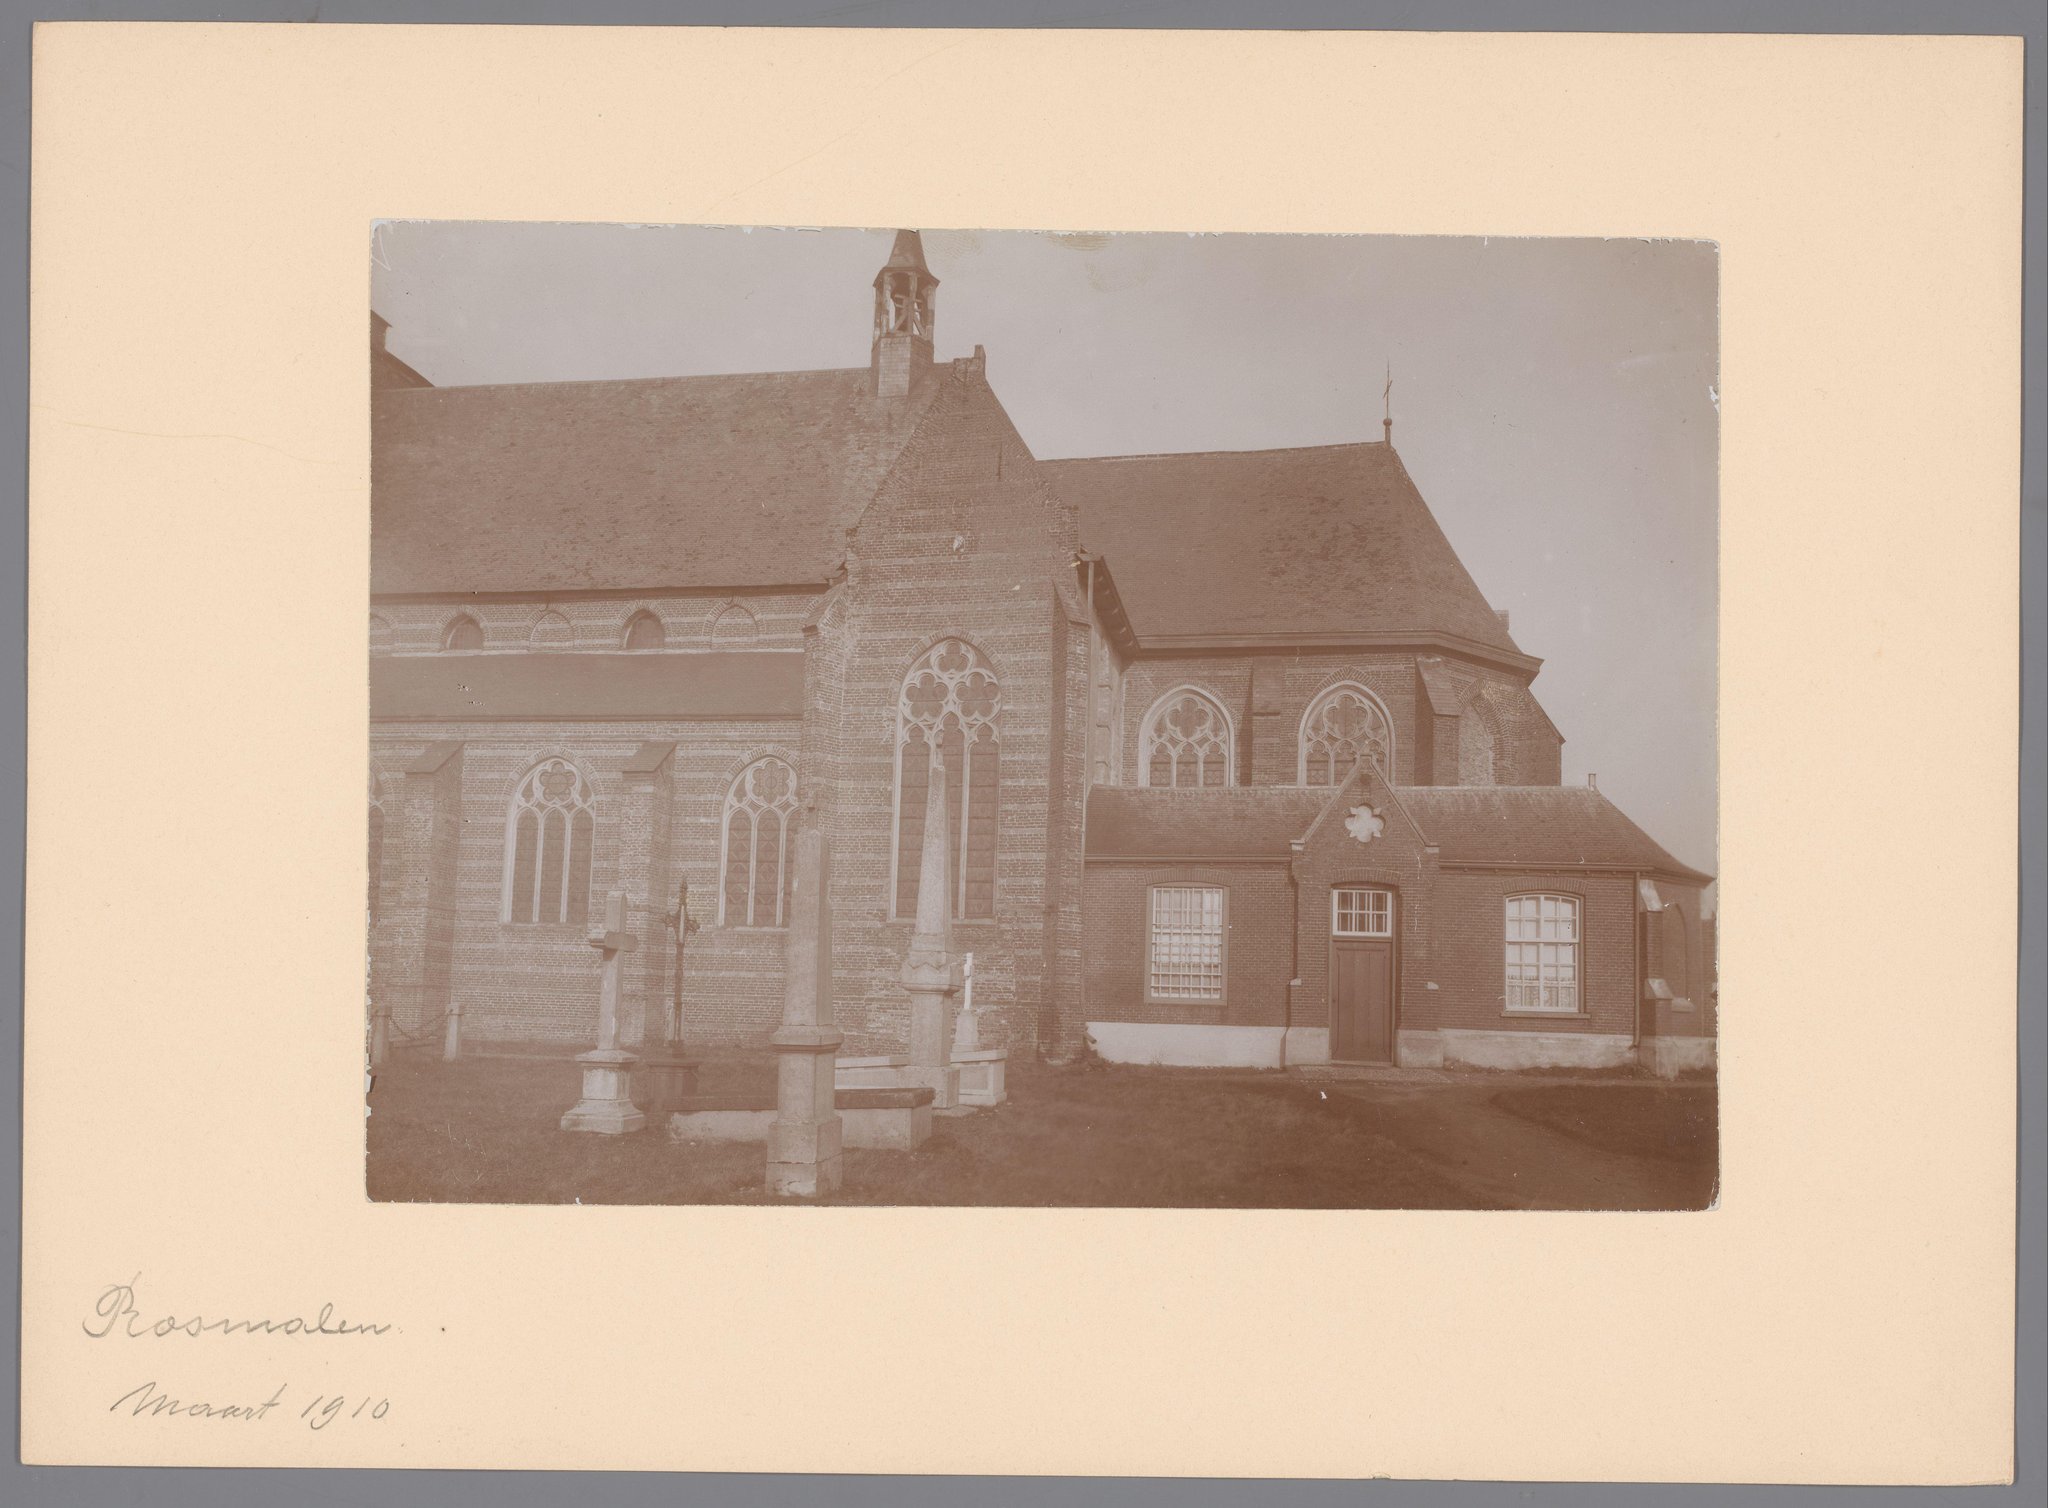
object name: photograph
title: Gedeelte van de Sint-Lambertuskerk te Rosmalen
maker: anoniem (monumentenzorg)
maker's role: fotograaf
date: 1910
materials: cardboard, photographic support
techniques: collodion silver print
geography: rosmalen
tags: church (exterior), rosmalen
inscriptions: annotation: ‘Rosmalen/ Maart 1910’